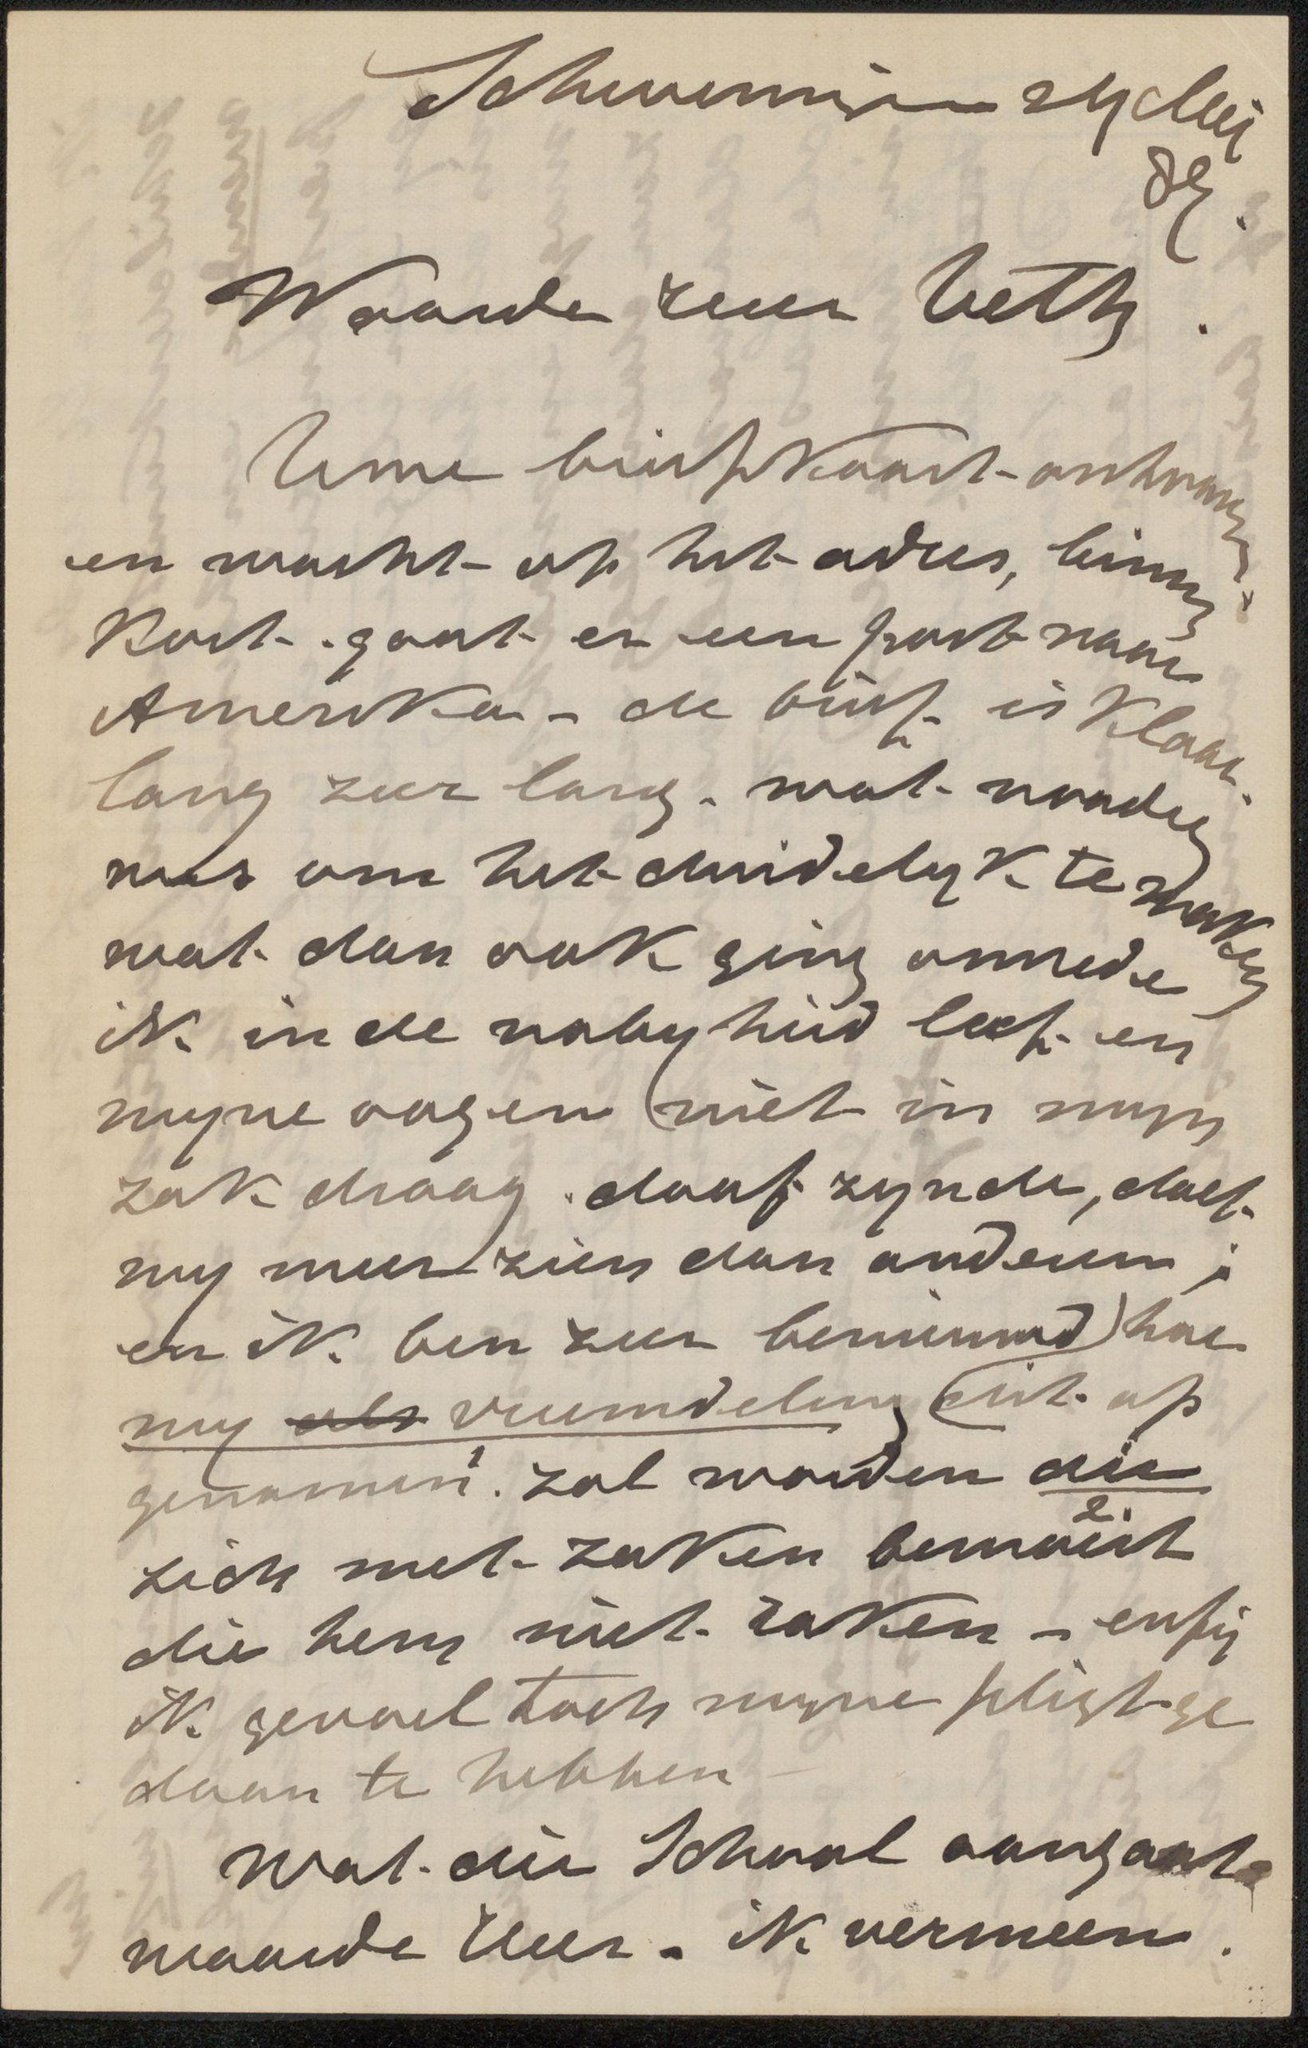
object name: letter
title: Brief aan Jan Veth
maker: paul joseph constantin gabriël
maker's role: draughtsman, print maker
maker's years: 1828-1903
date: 1887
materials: ink, paper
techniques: pen, writing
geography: scheveningen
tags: dordrecht, painter, designer, jan veth, artist, anna dorothea dirks, anonymous historical person portrayed, painting (including book-illumination, miniature-painting)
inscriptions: collector's mark: ‘RPK’